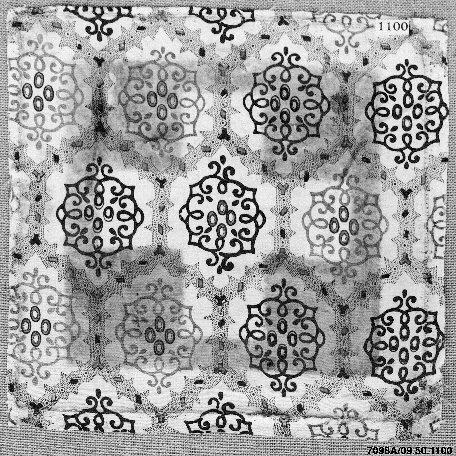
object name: textile fragment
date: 1801-1900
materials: silk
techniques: printing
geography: india